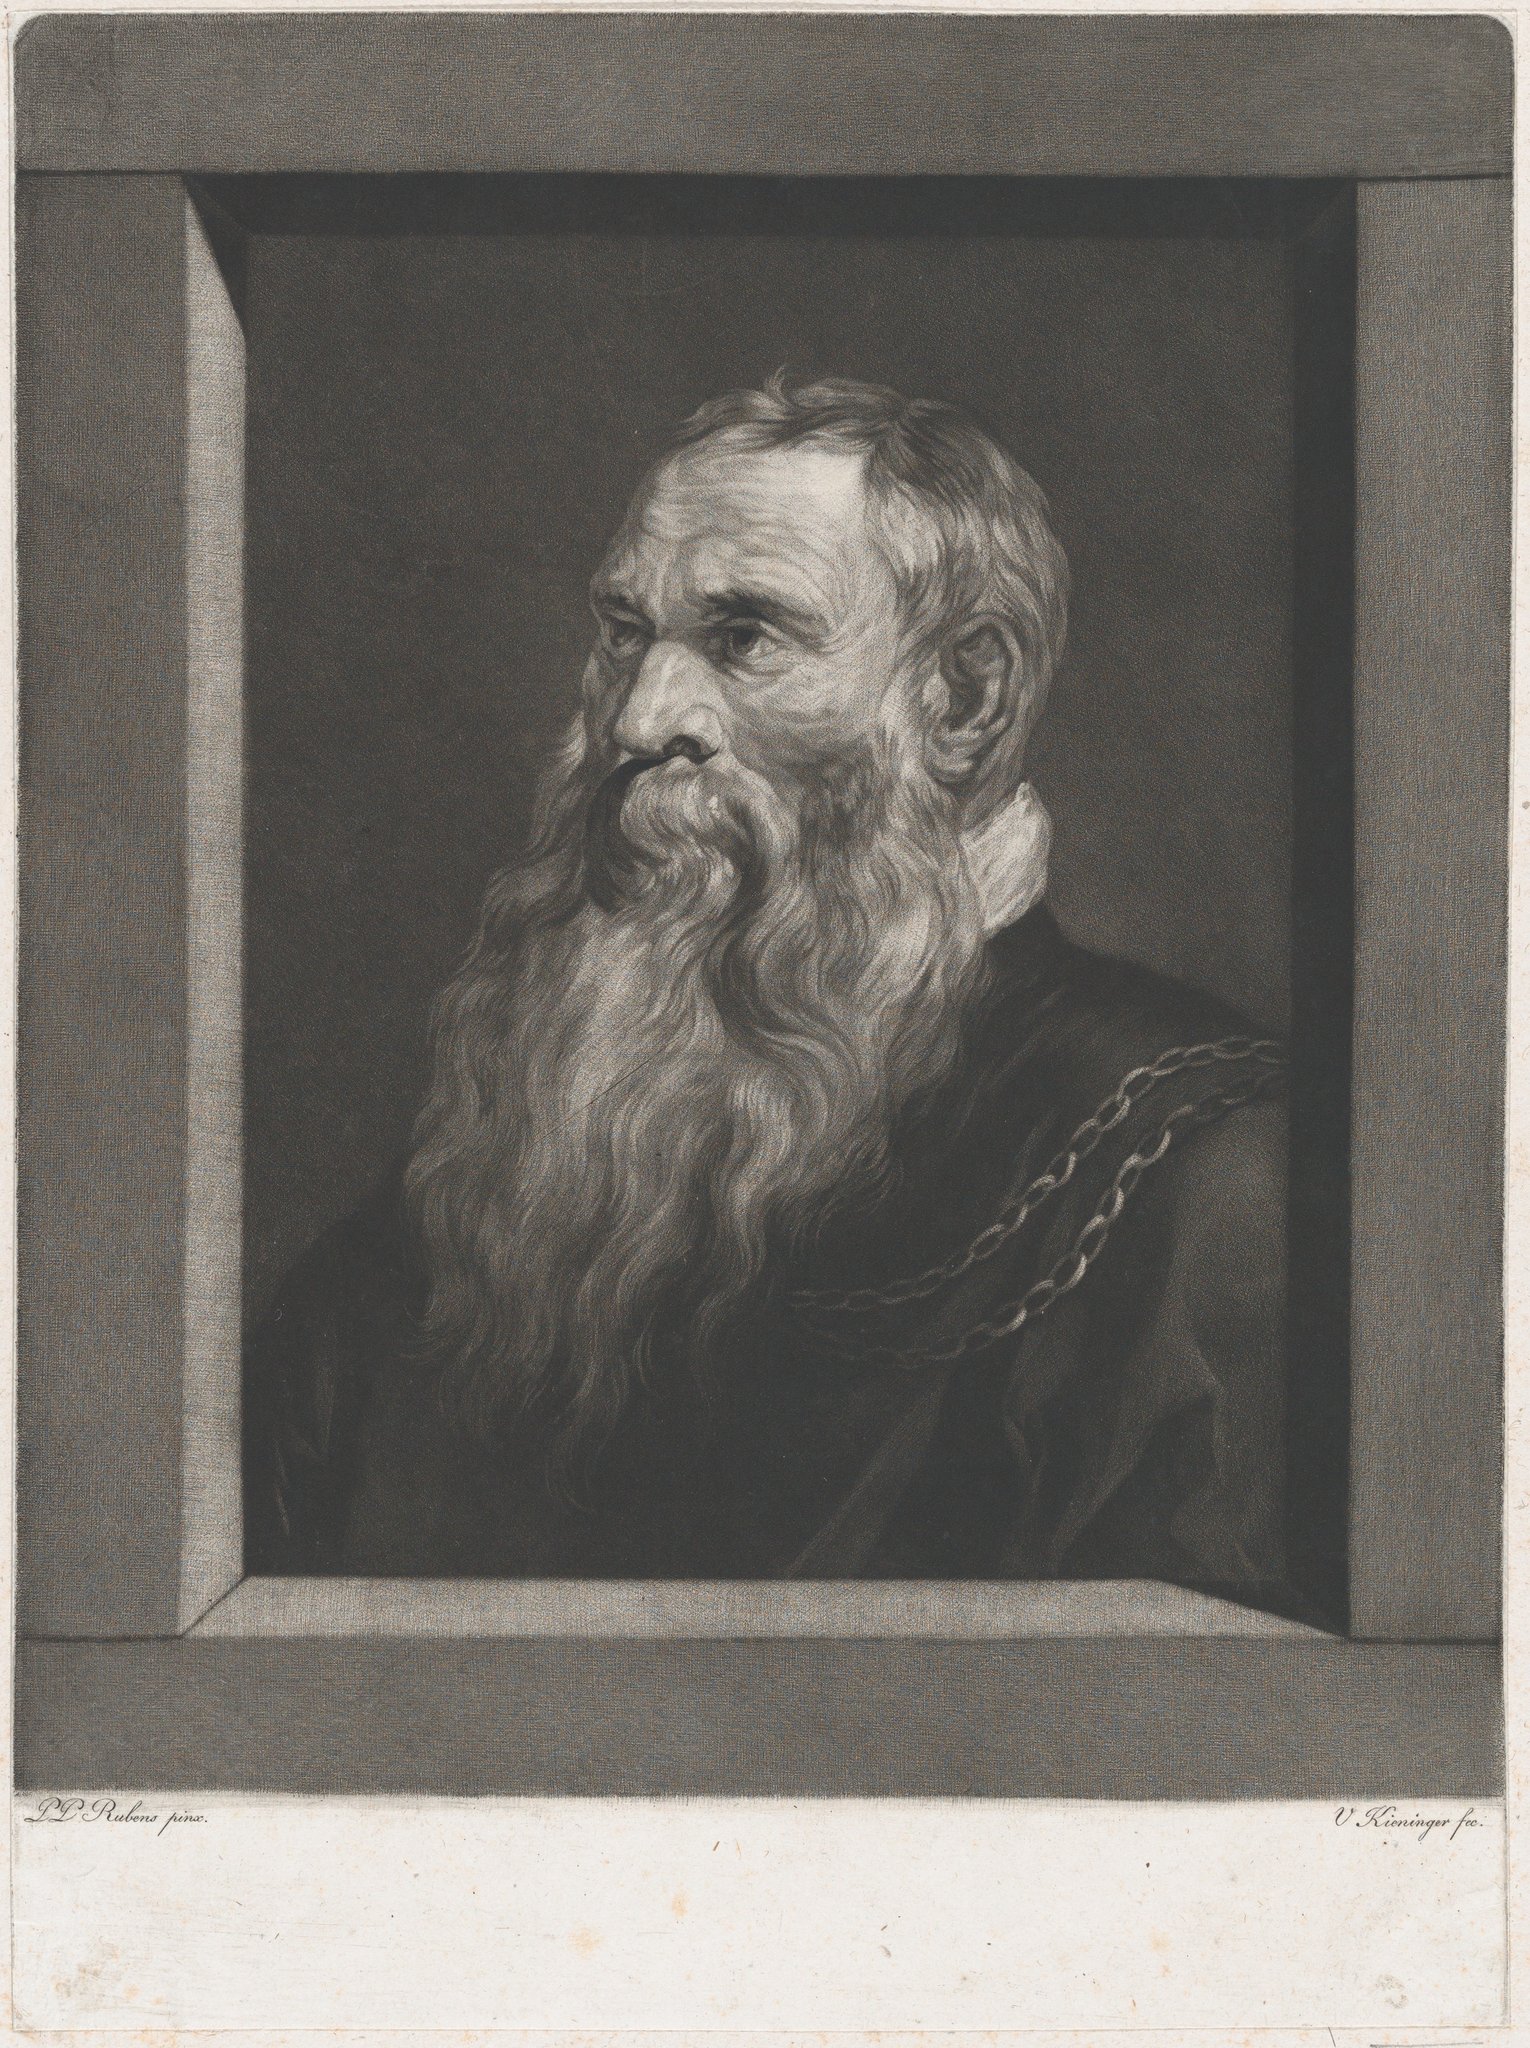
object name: print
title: Portrait of an old man with a beard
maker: vincenz georg kininger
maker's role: artist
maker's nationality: austrian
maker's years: 1767-1851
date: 1787-1851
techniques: mezzotint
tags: men,portraits